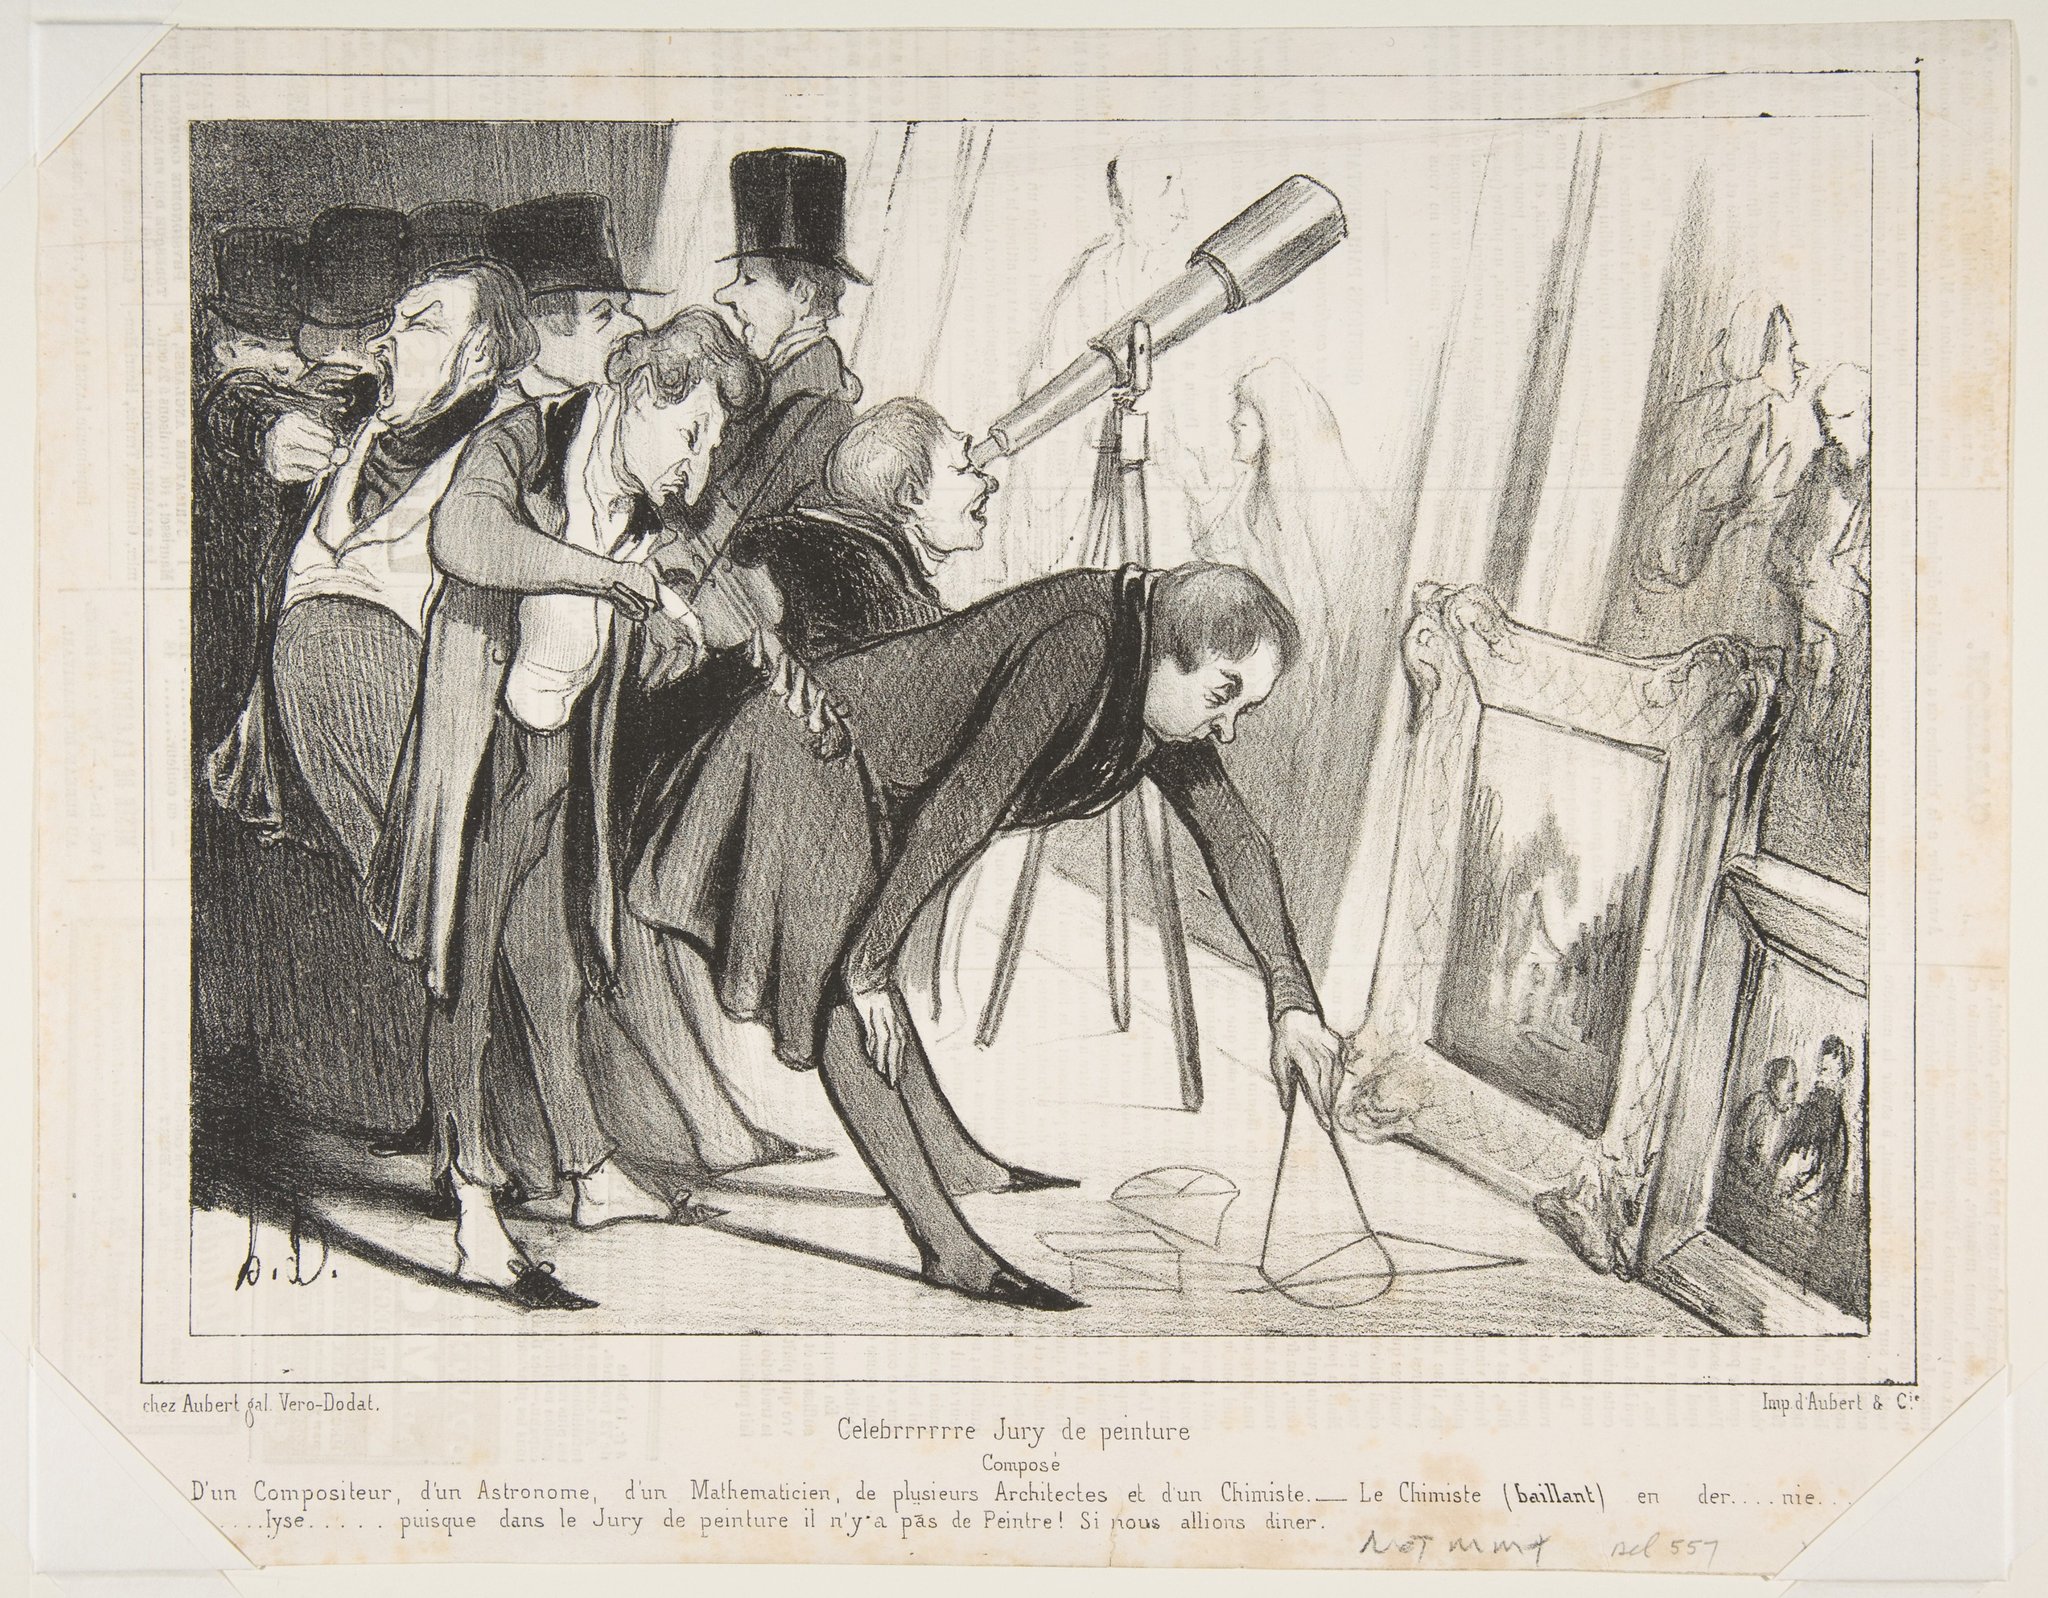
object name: print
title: Celebrrrre Jury de Peinture..., published in Le Charivari, March 16, 1840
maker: honoré daumier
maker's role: artist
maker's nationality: french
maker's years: 1808-1879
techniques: lithograph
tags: satire,men,geometry,telescopes